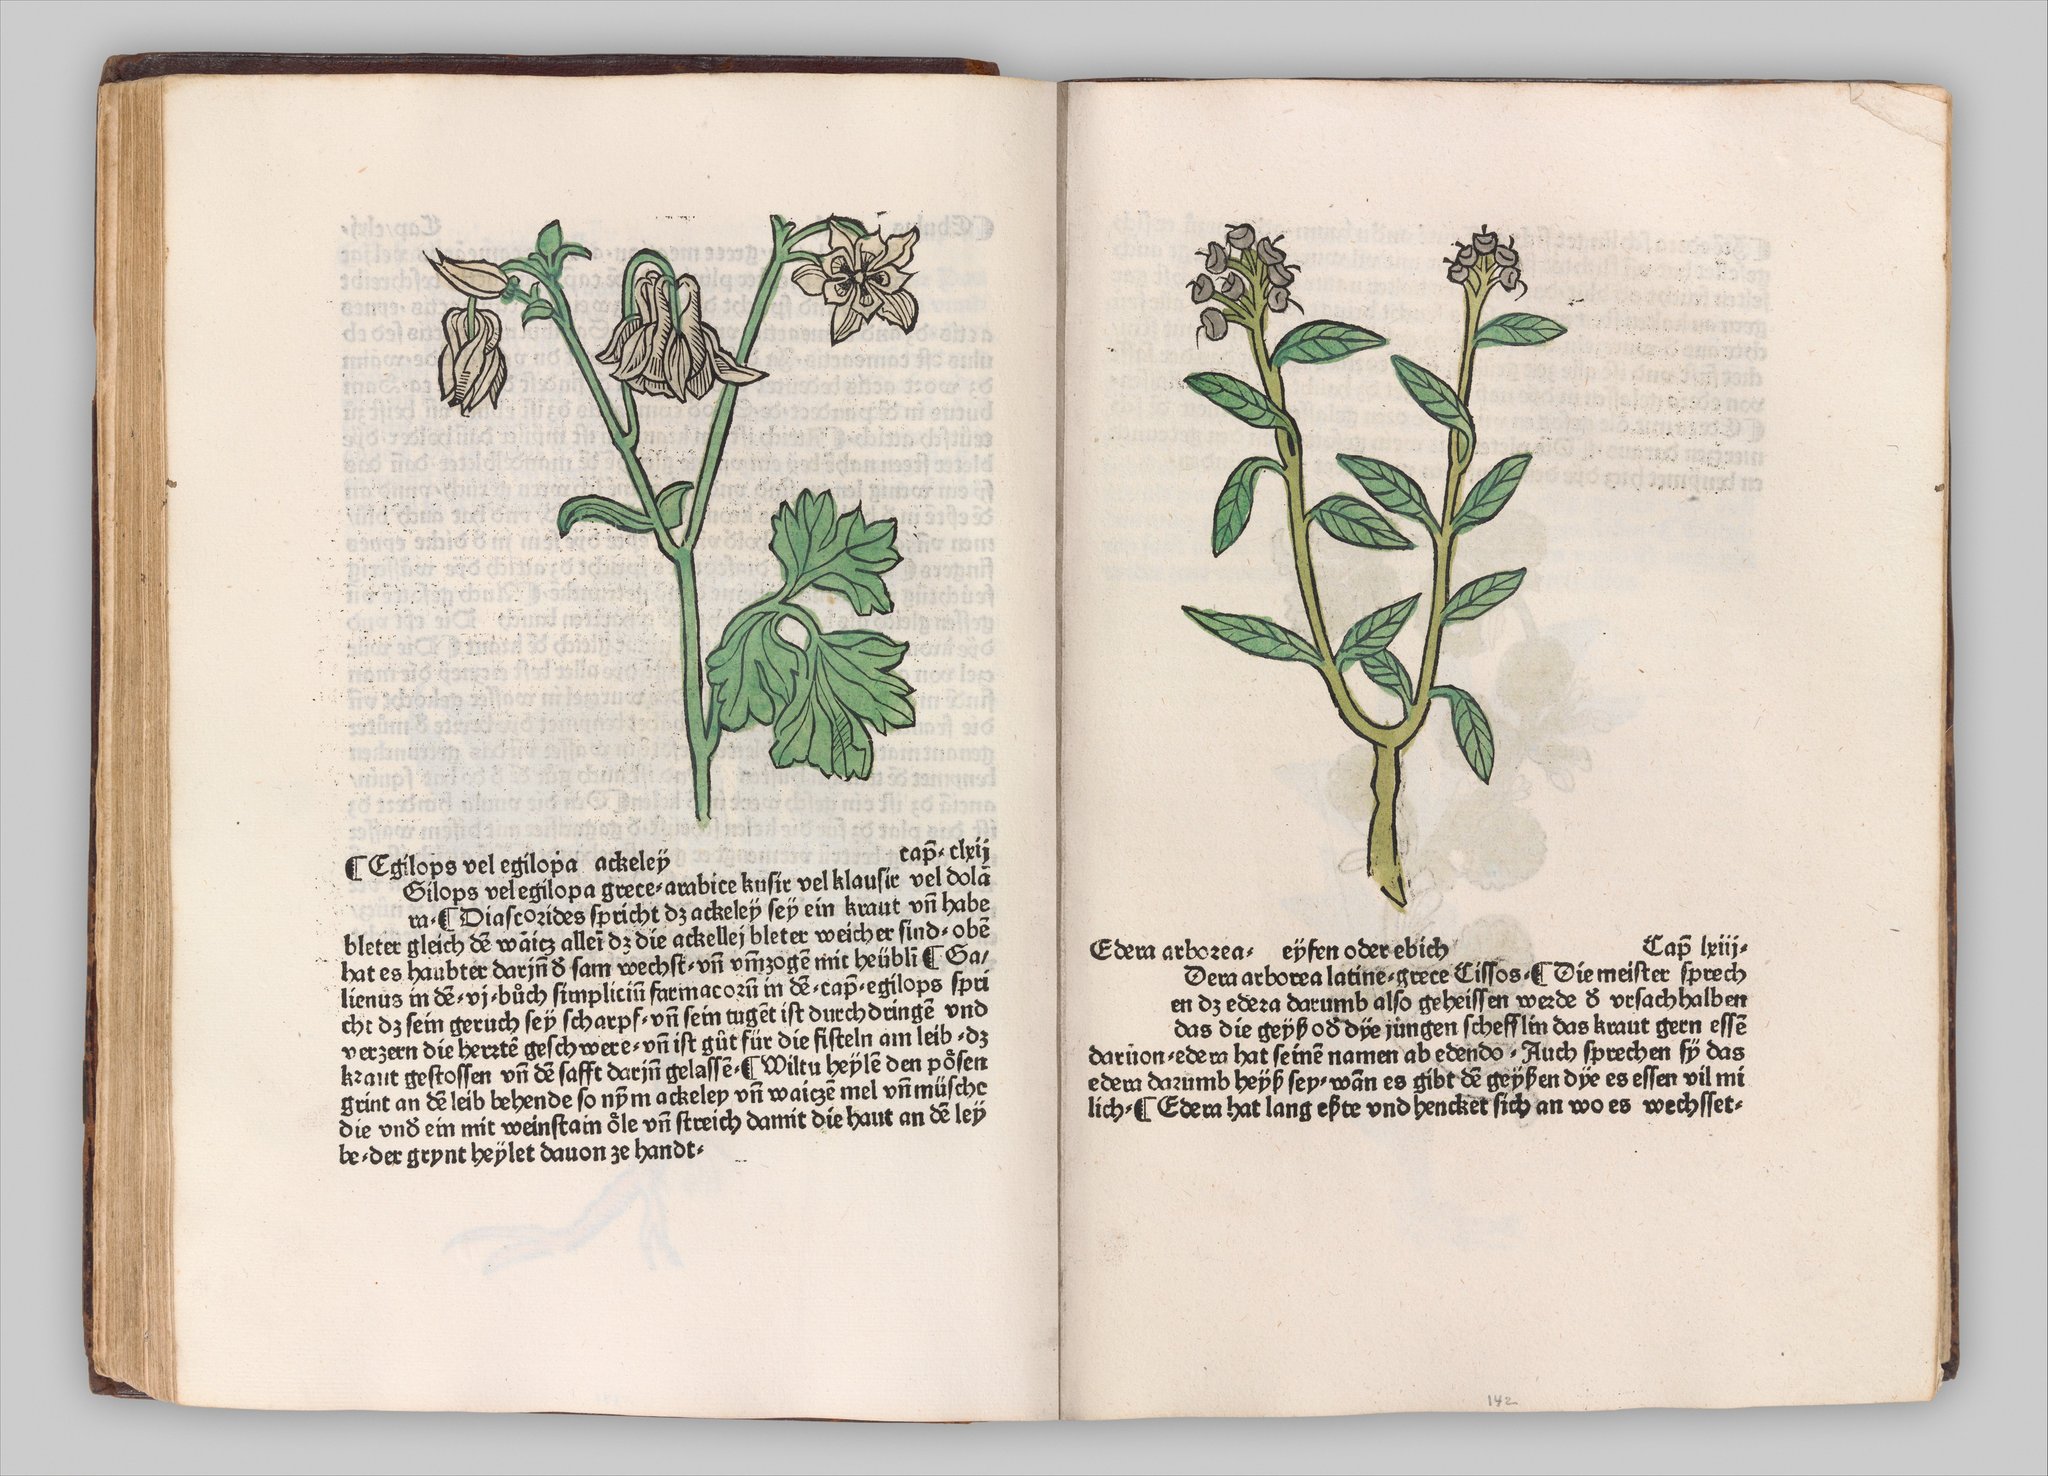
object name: book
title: Herbarius - Gart der gesuntheit - Hortus sanitatis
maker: hans schönsperger the elder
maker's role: publisher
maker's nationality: german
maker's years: 1481-1520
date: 1485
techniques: hand coloring, woodcut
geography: germany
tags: flowers